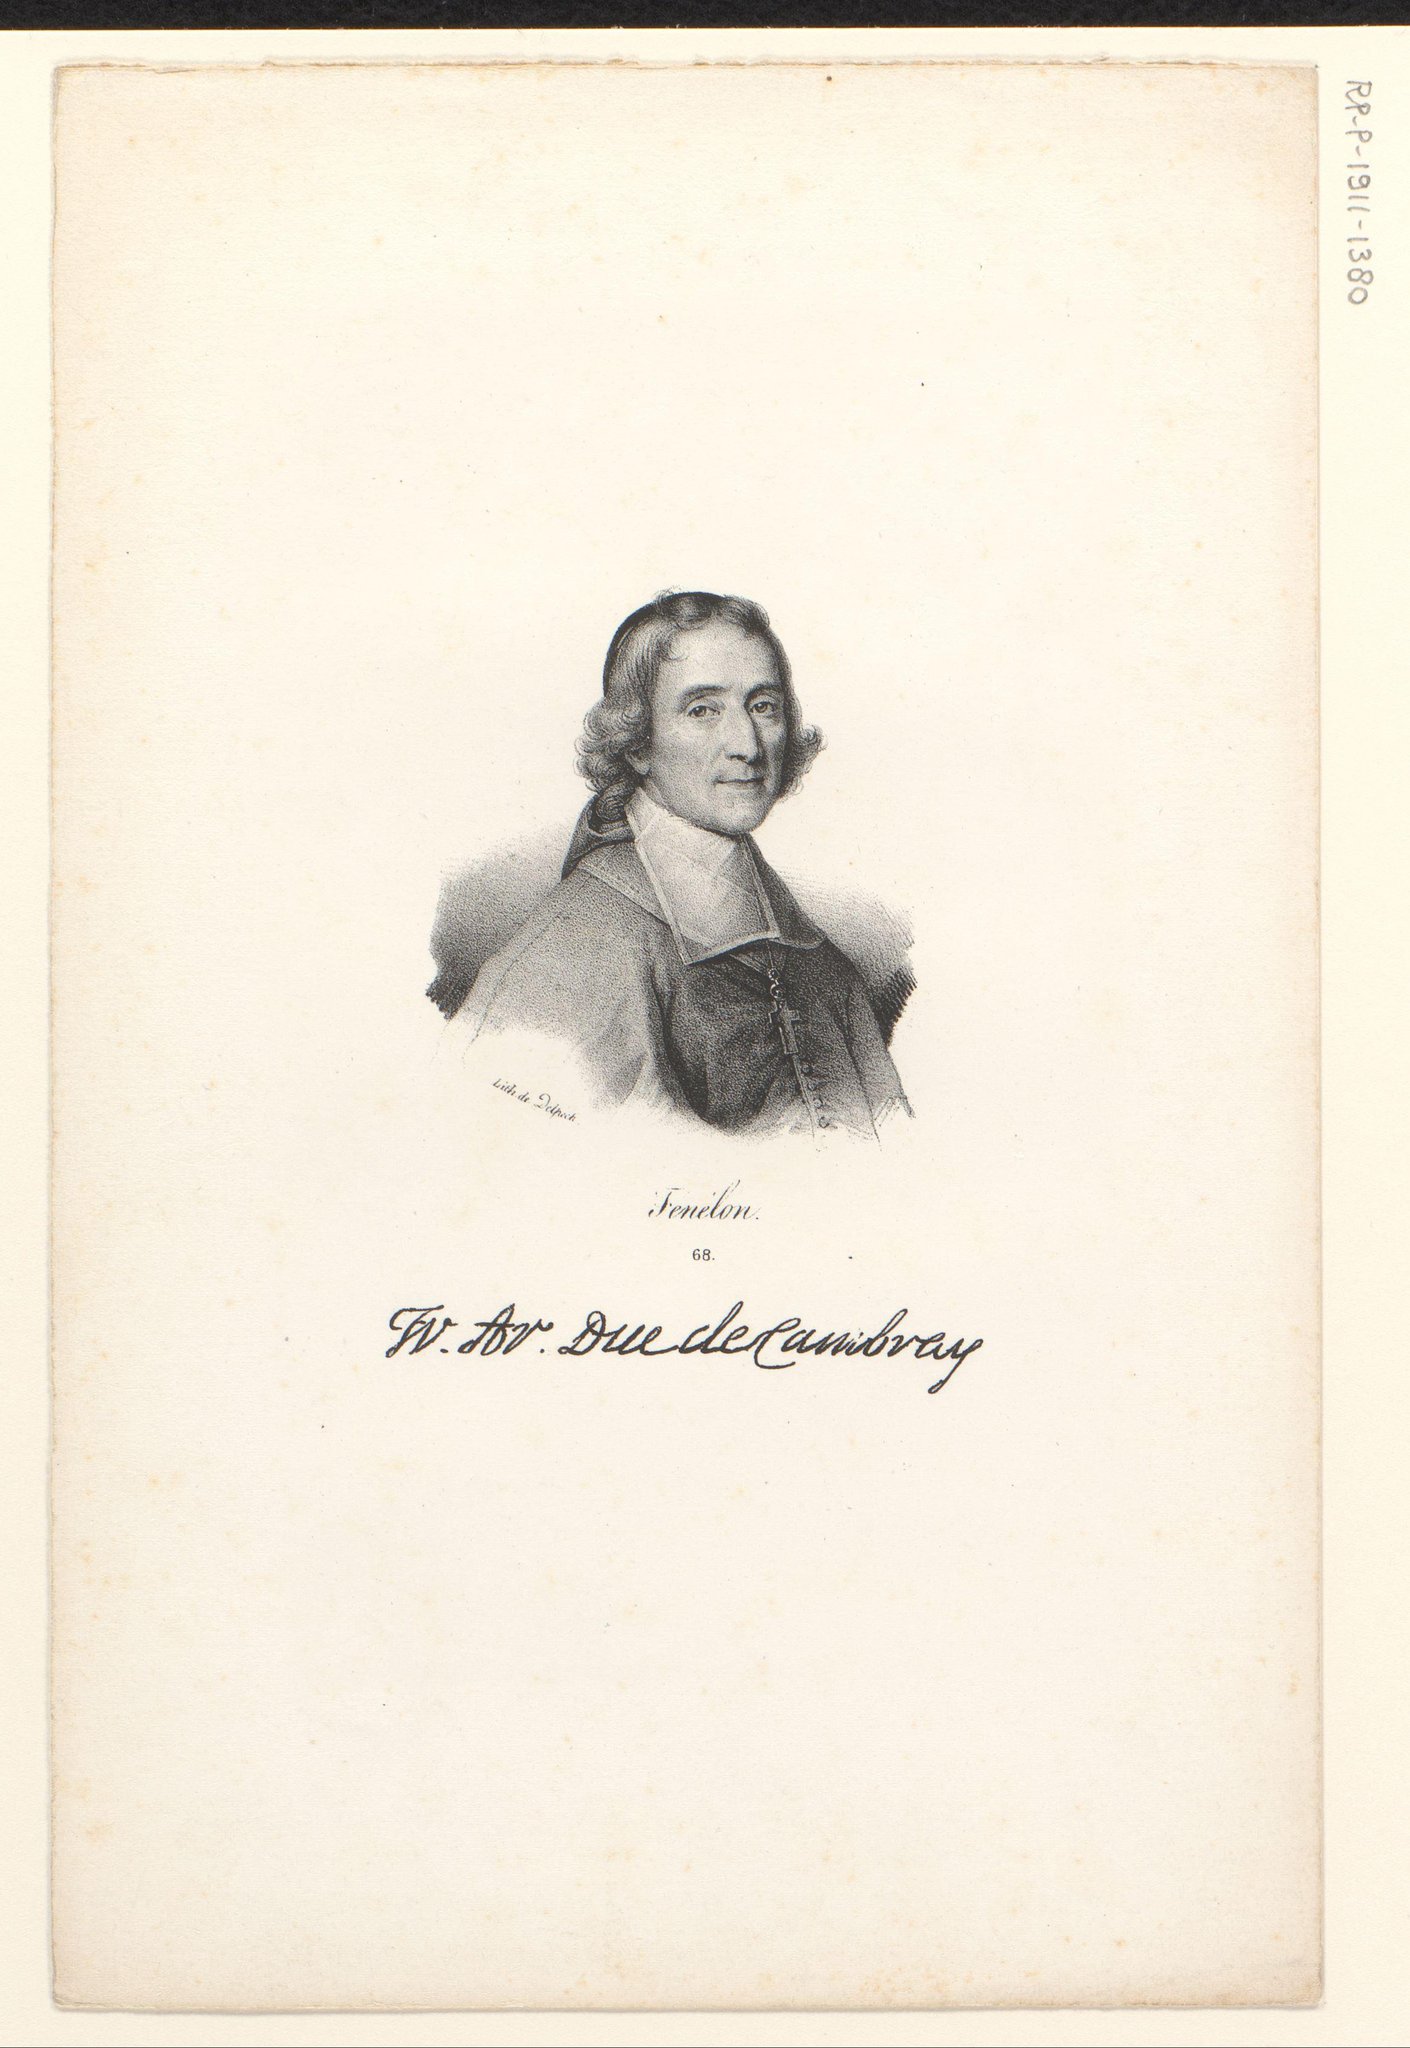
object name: print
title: Portret van François Fénelon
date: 1818-1842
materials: paper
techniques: lithograph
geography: paris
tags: françois fénelon, historical persons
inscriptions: collector's mark: Lugt 2228a